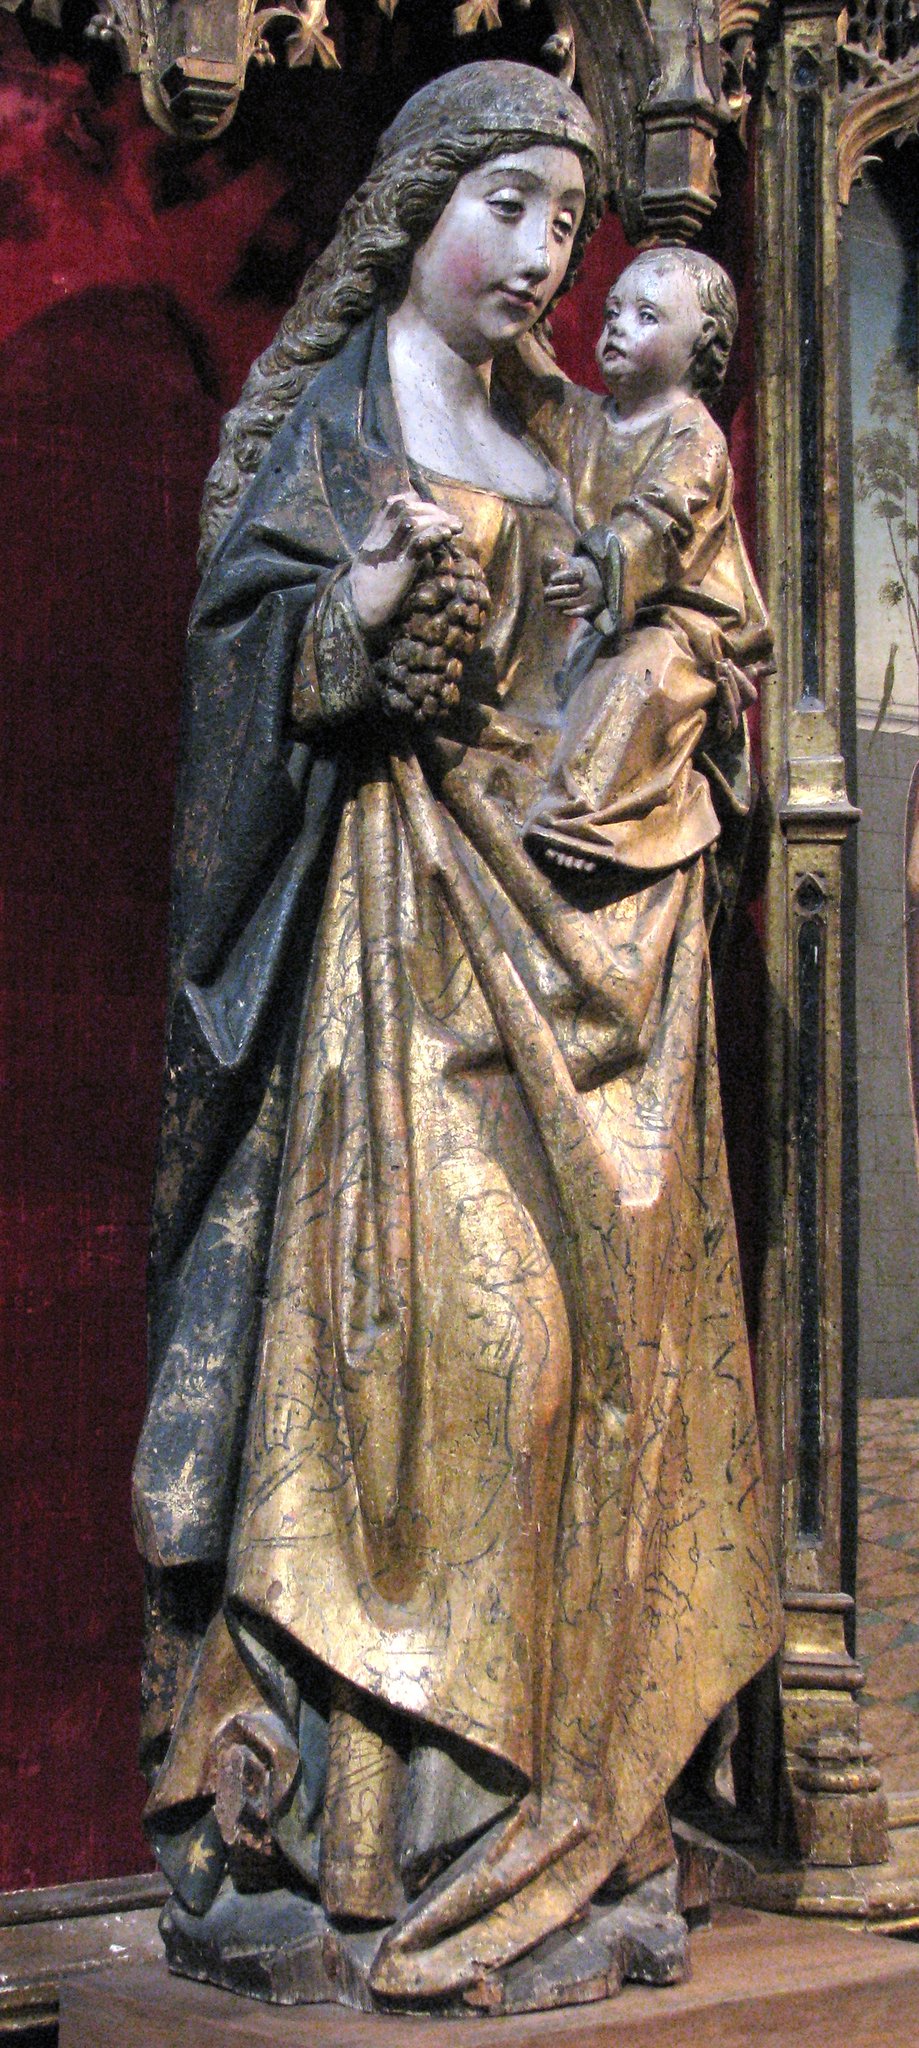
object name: statue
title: Virgin and Child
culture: spanish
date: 1401-1500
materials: paint, wood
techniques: gilding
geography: spain